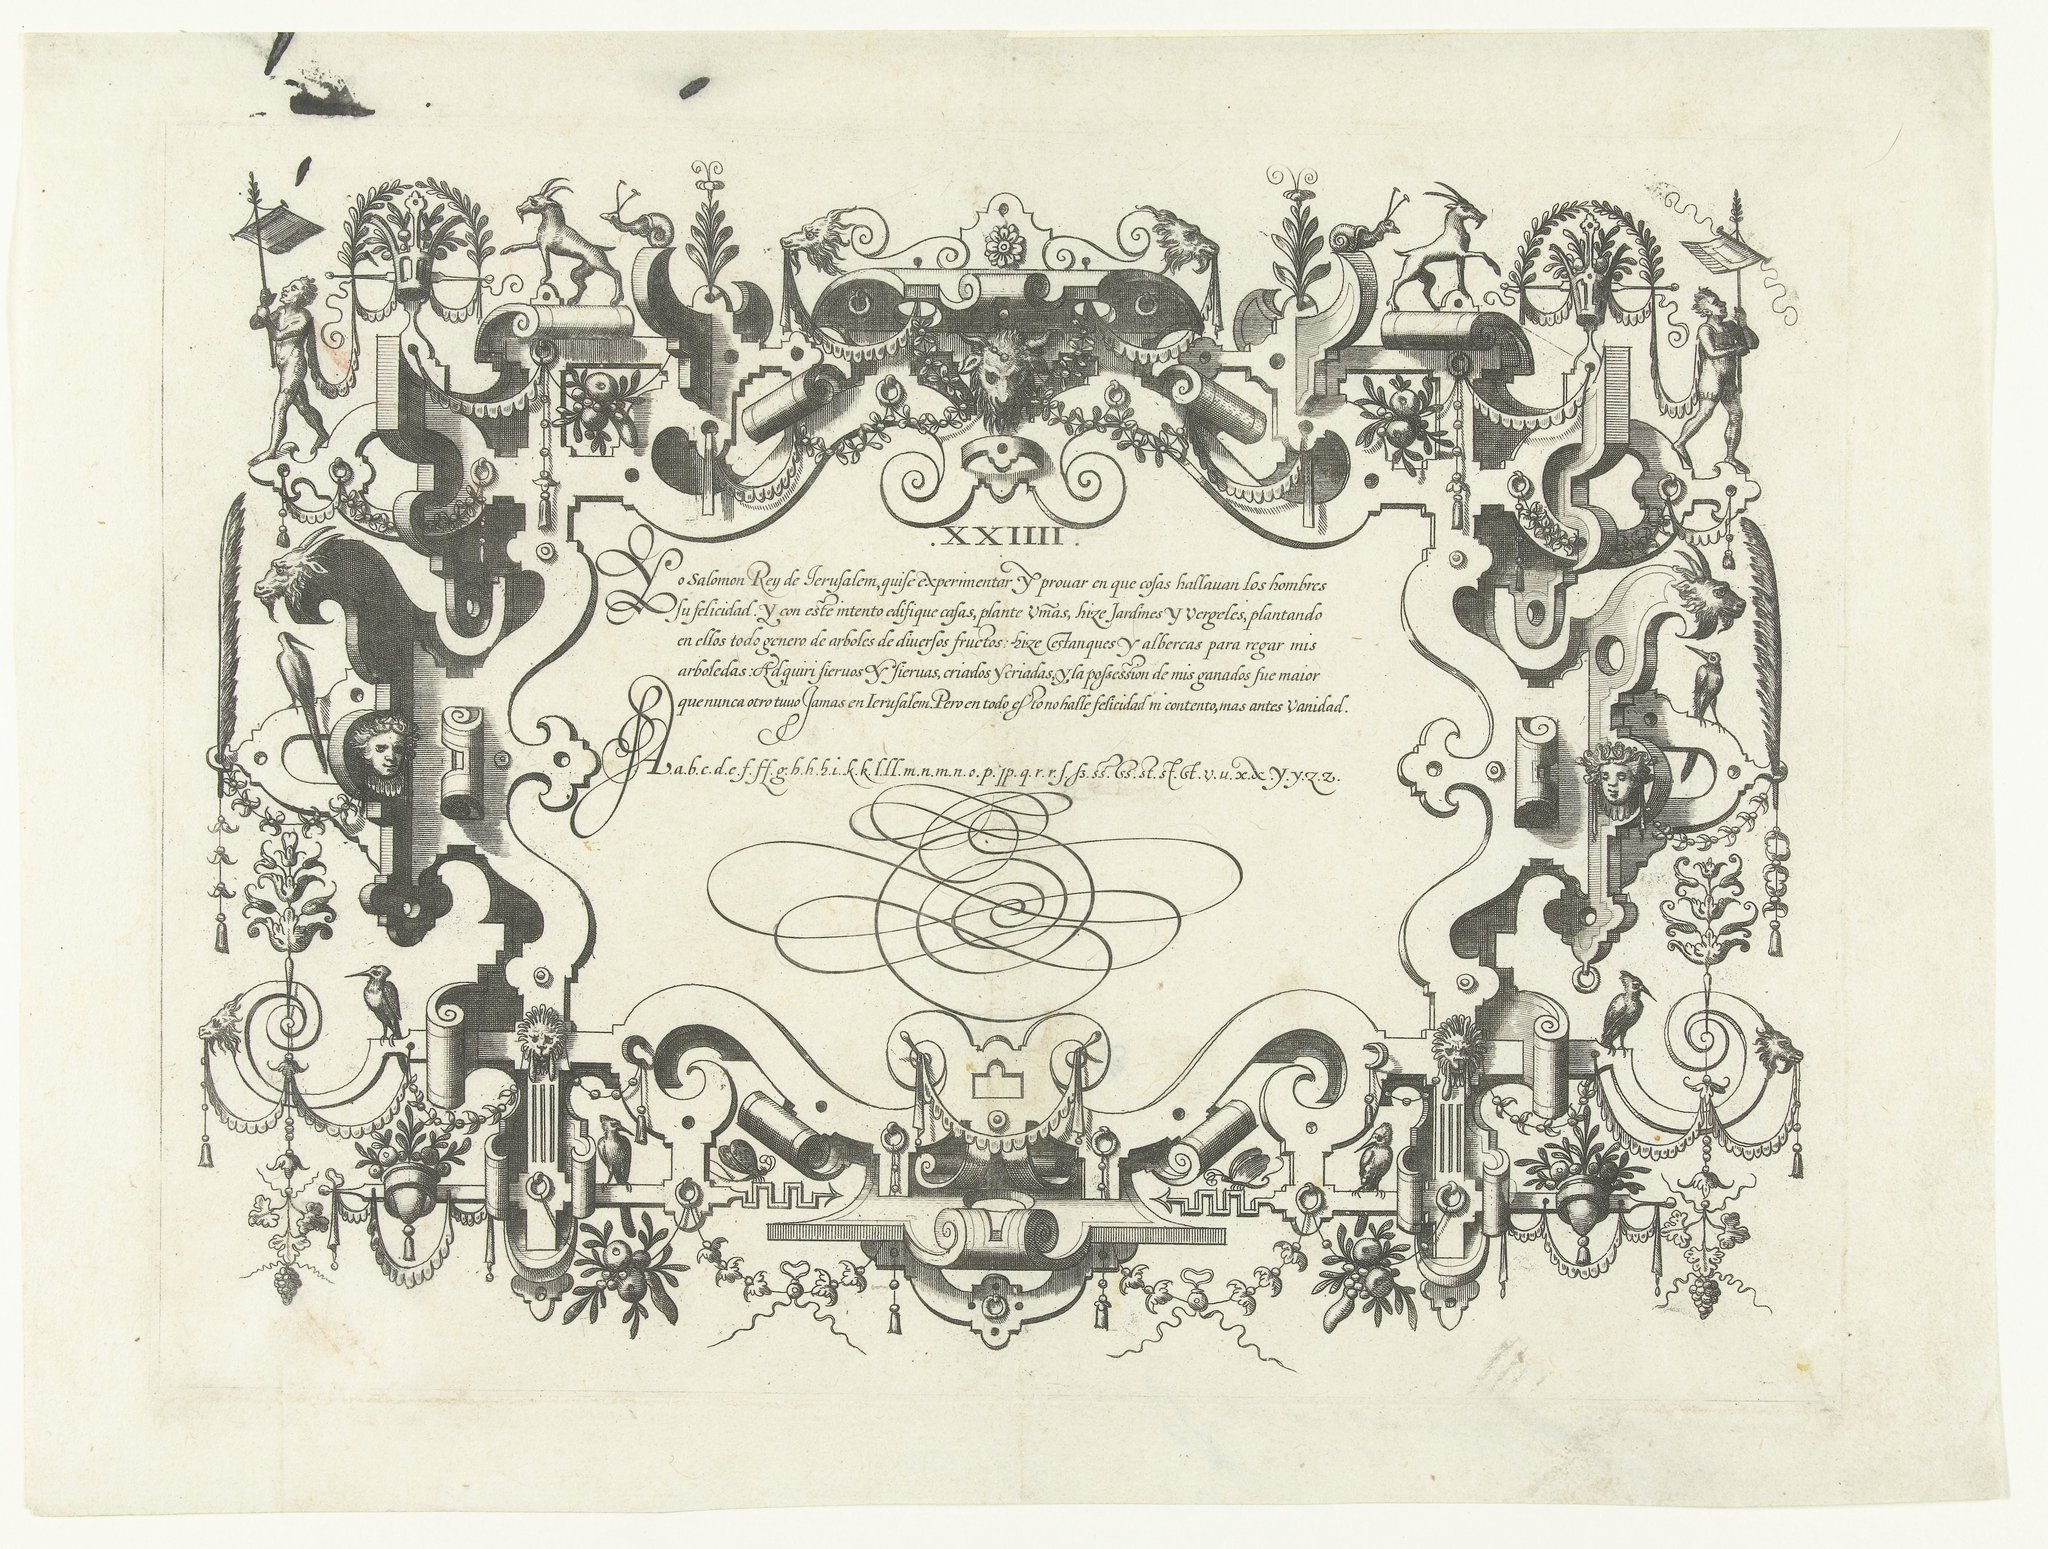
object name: print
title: Cartouche met kalligrafie, links- en rechtsboven een man met vaandel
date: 1569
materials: paper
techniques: engraving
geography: antwerp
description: Blad XXIIII. Cartouche met de tekst Yo Salomon Rey de Jerusalem. Op het rolwerk bovenaan staan twee bokken op hun achterpoten en zitten twee slakken. Uit serie van 21 genummerde cartouches met kalligrafie in een omlijsting van rol- en beslagwerk met grotesken, guirlandes en mascarons.